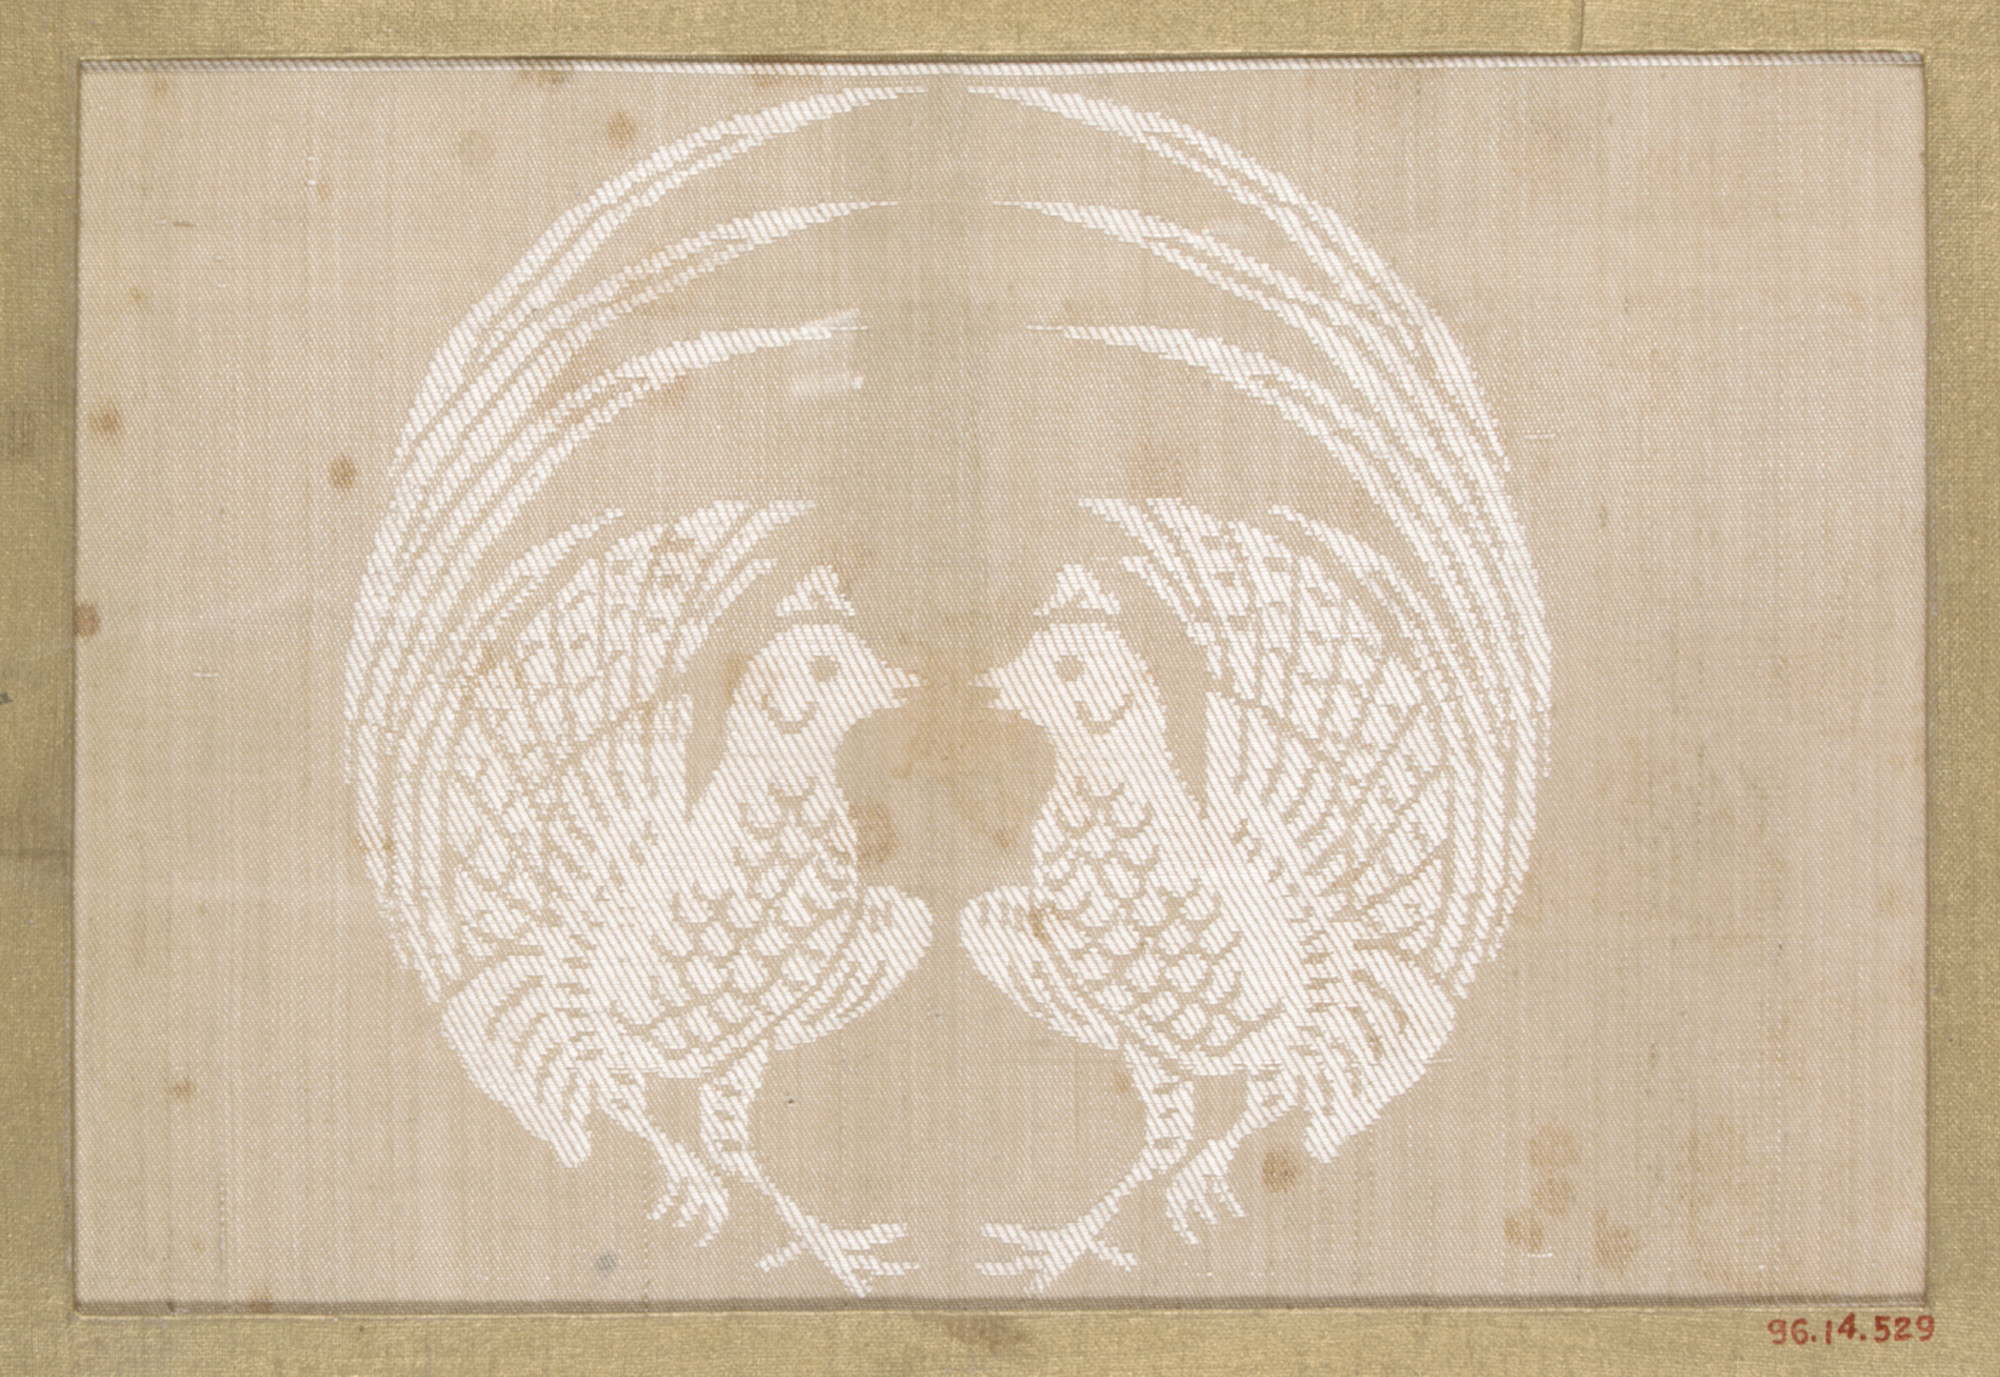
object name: piece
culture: japanese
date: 1701-1900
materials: silk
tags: birds